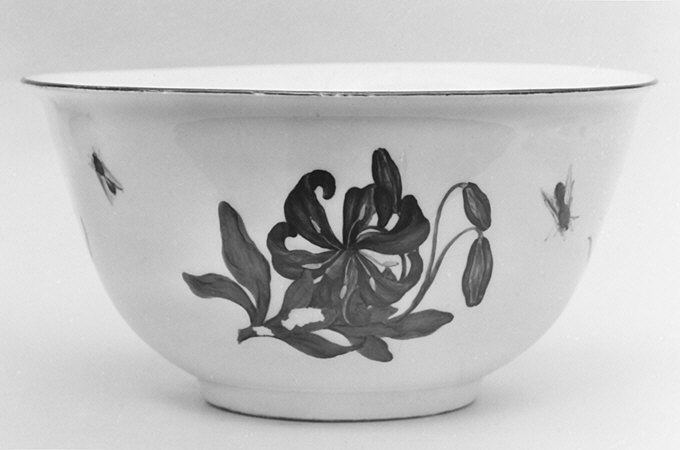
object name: bowl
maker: meissen manufactory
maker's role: manufactory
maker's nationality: german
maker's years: 1710-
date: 1740-1750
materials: hard paste porcelain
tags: insects,flowers